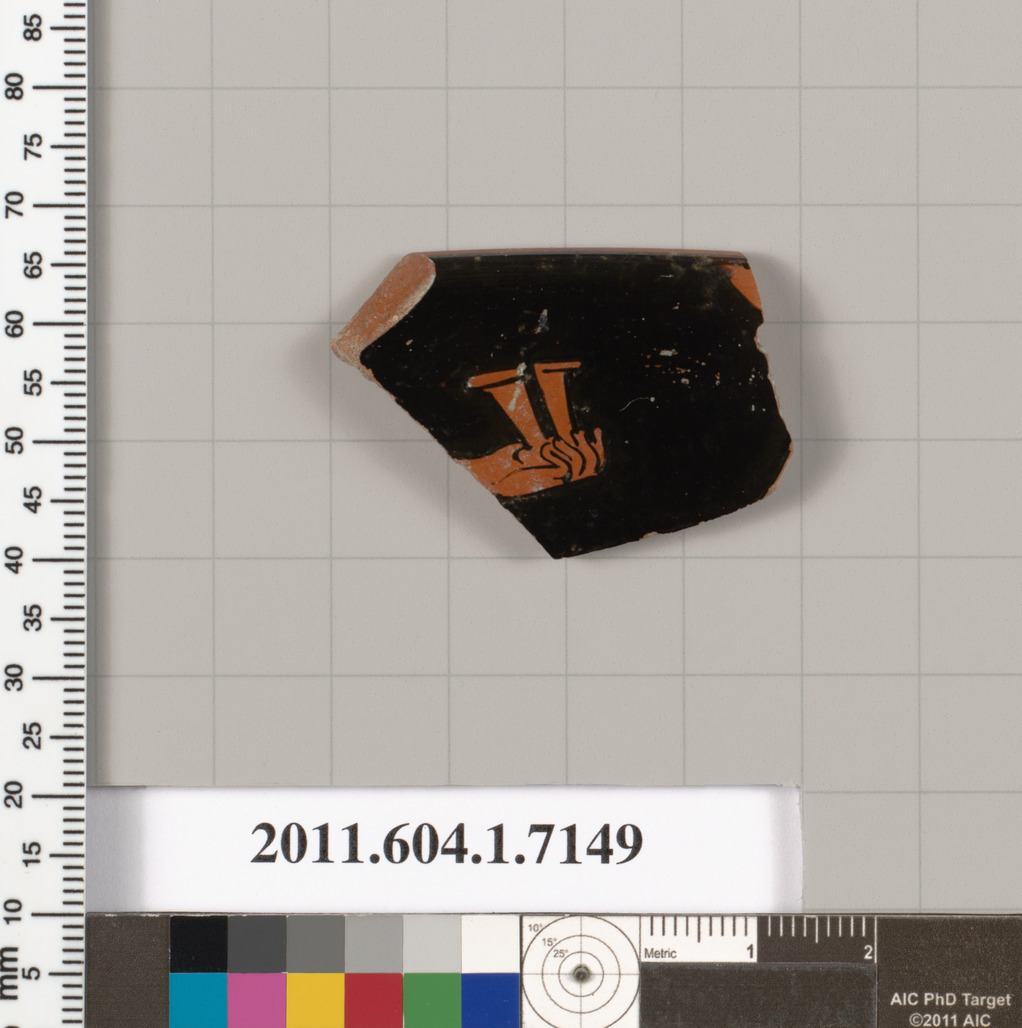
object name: kylix fragment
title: Terracotta rim fragment of a kylix (drinking cup)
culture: greek, attic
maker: makron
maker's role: artist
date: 500-480 BCE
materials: terracotta